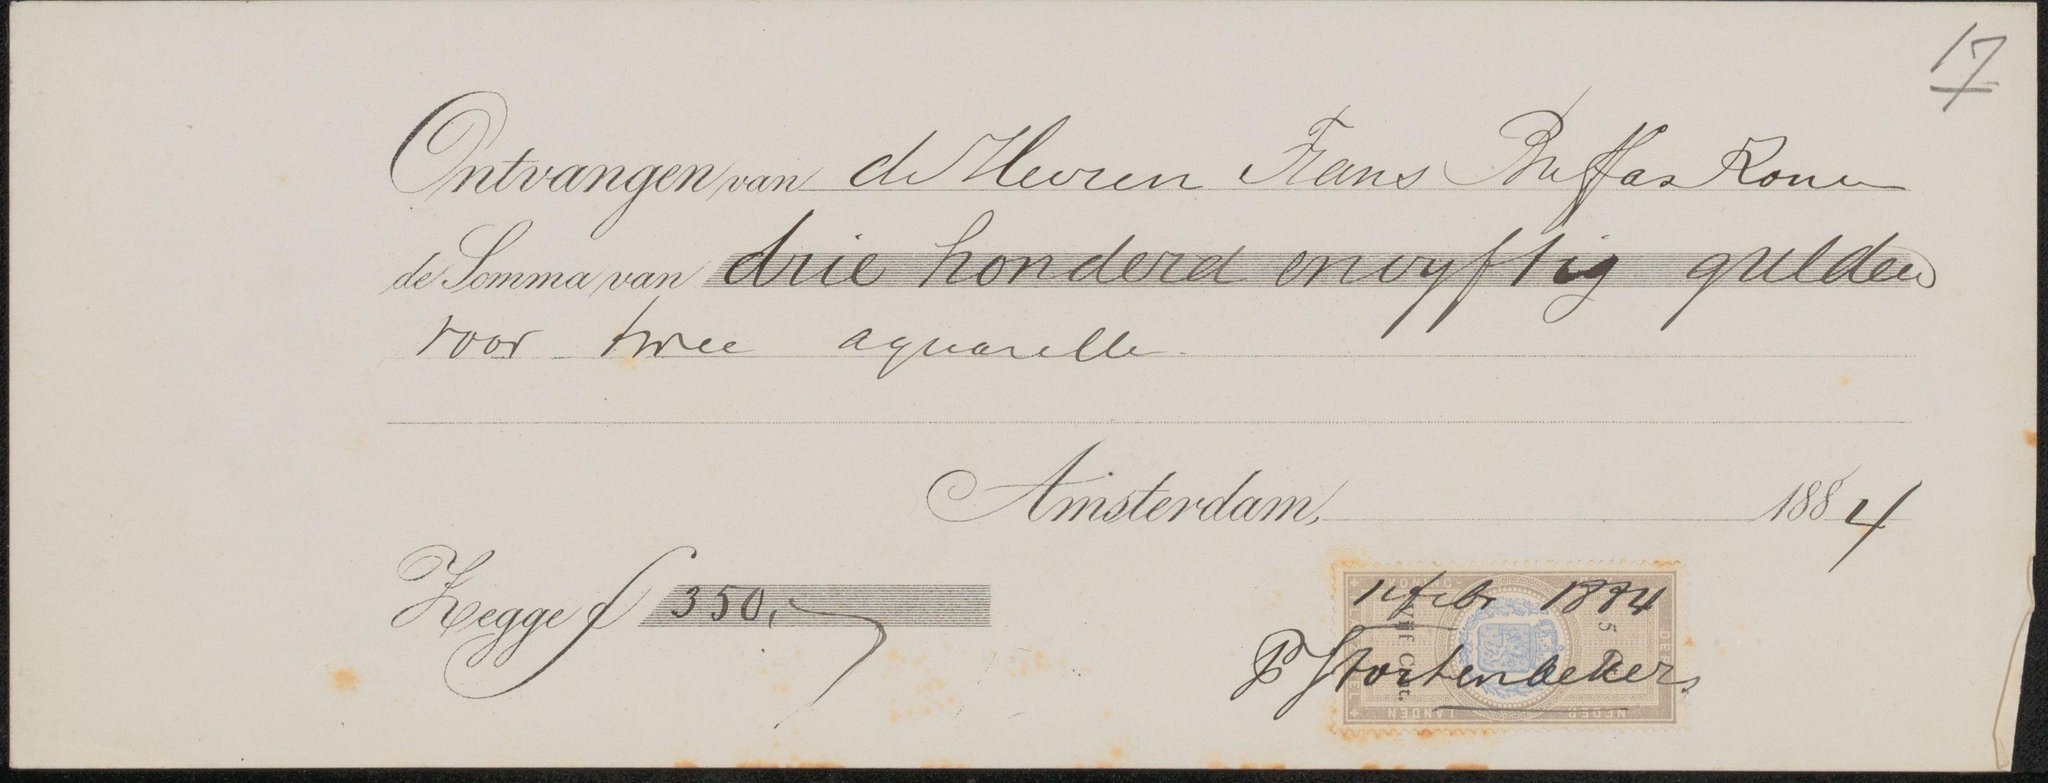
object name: ontvangstbewijs, kwitantie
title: Kwitantie voor Pieter Stortenbeker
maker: pieter stortenbeker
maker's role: draughtsman, painter, print maker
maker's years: 1828-1898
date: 1884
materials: ink, paper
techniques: pen, printing, writing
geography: amsterdam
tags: drawing, money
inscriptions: collector's mark: Lugt 2233